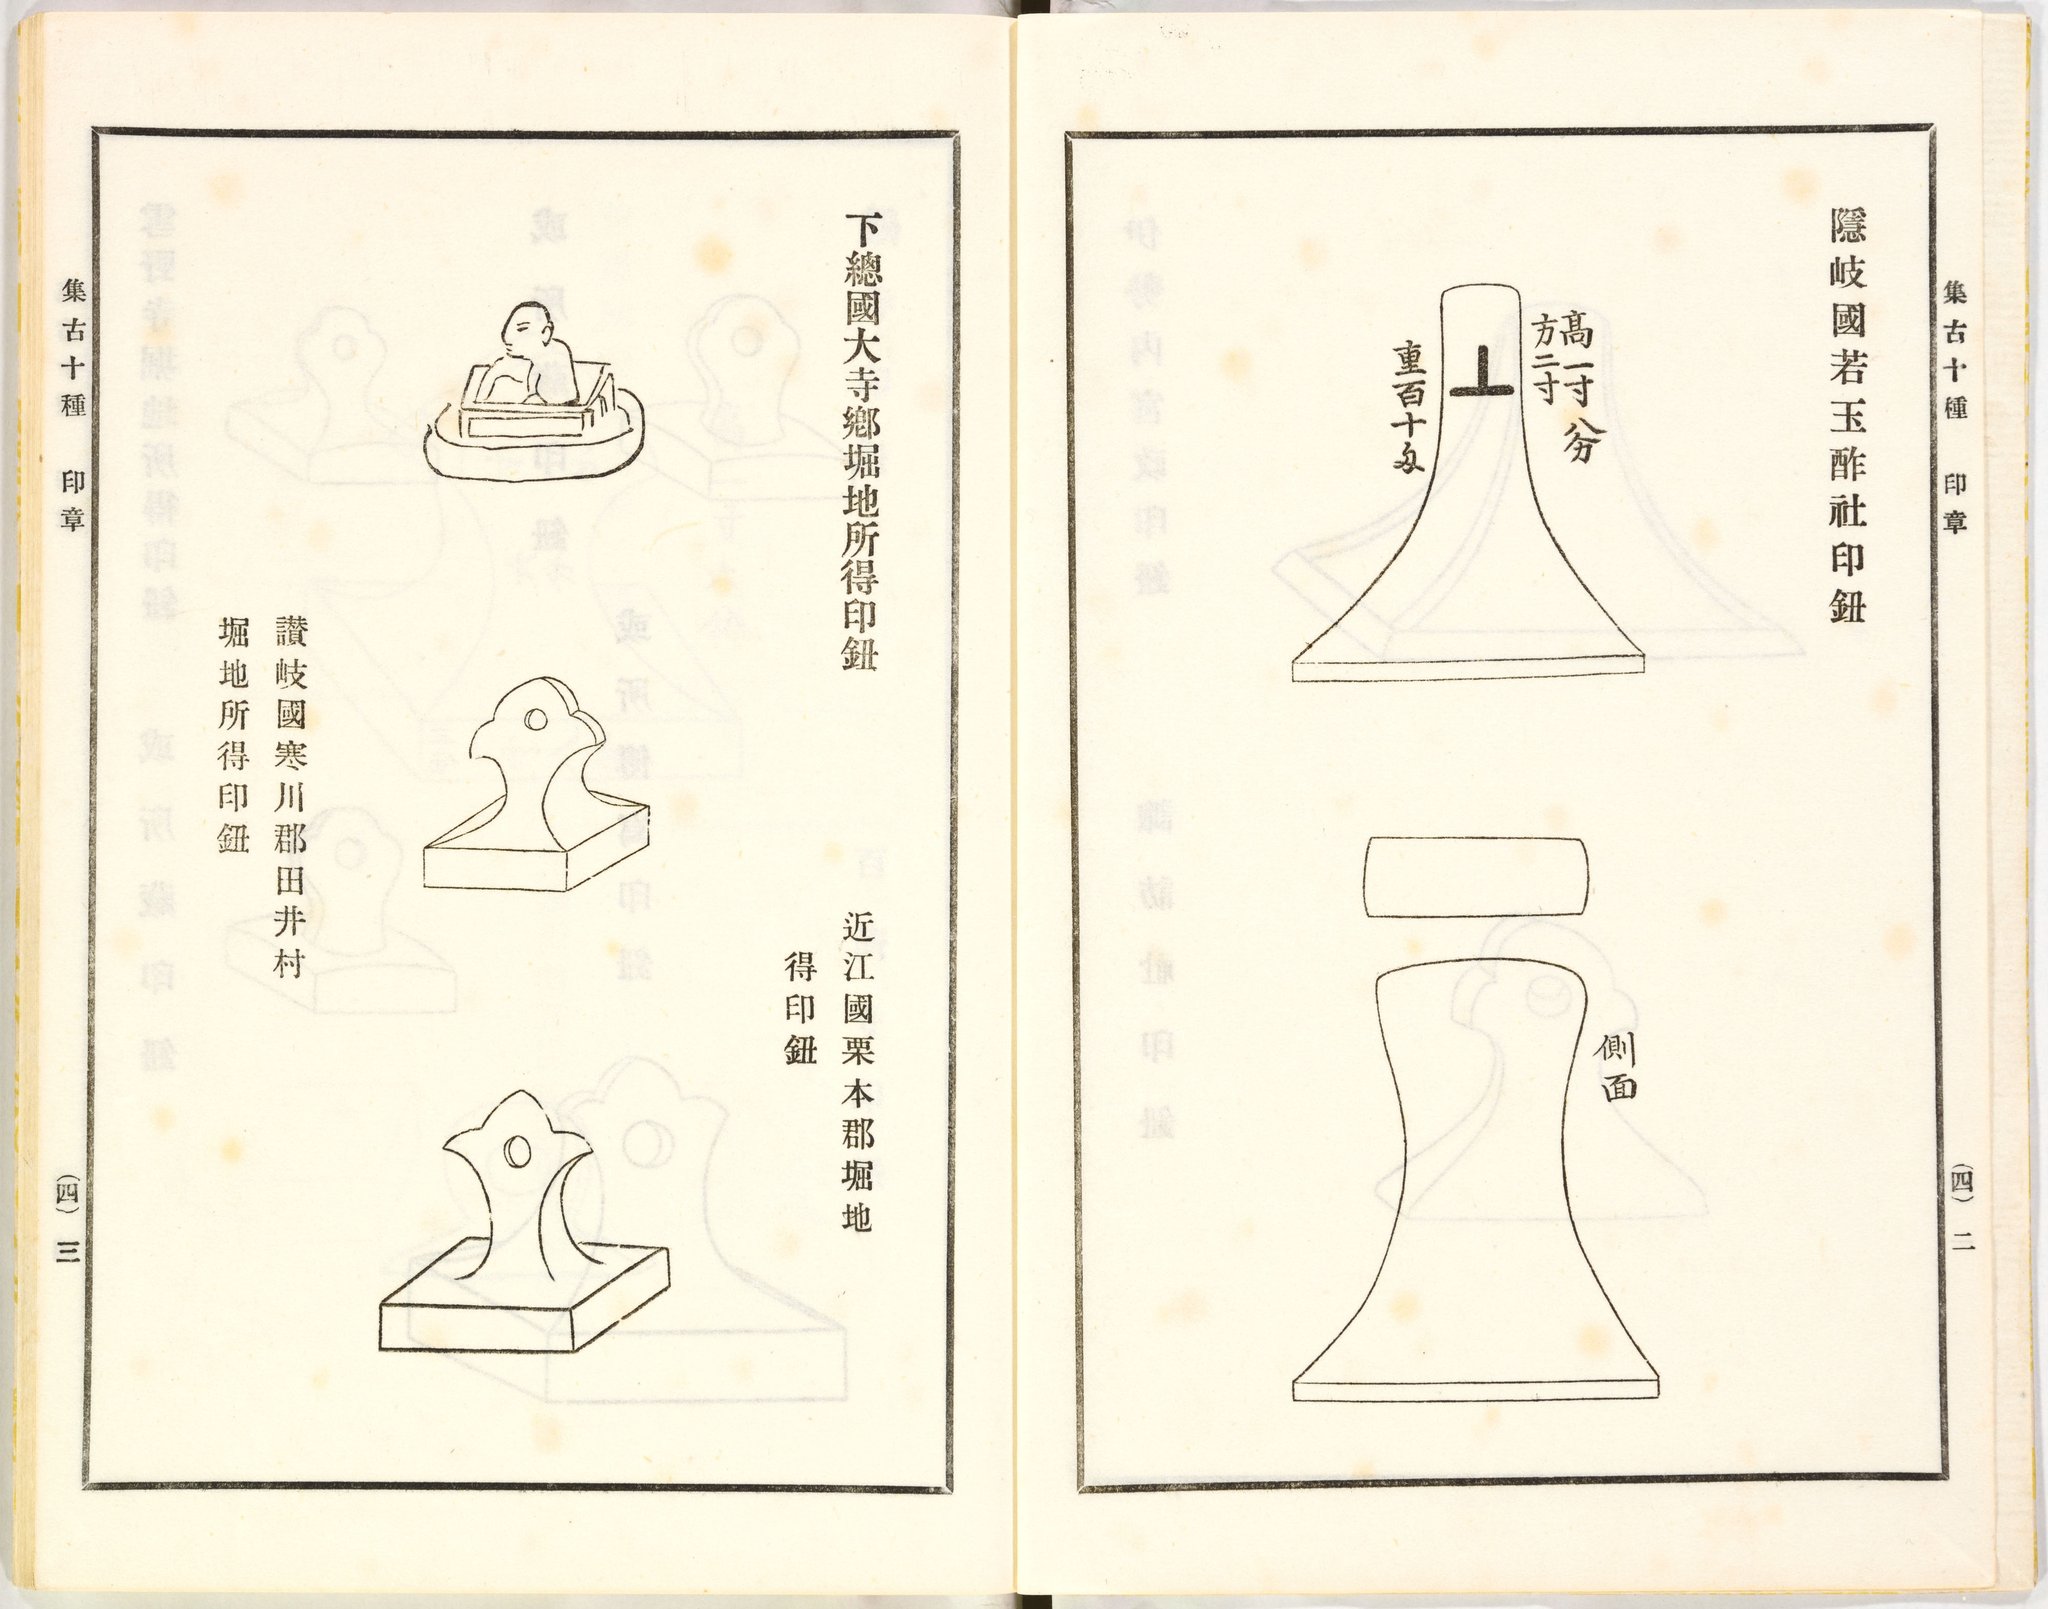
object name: illustrated book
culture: japanese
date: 1893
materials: ink, paper